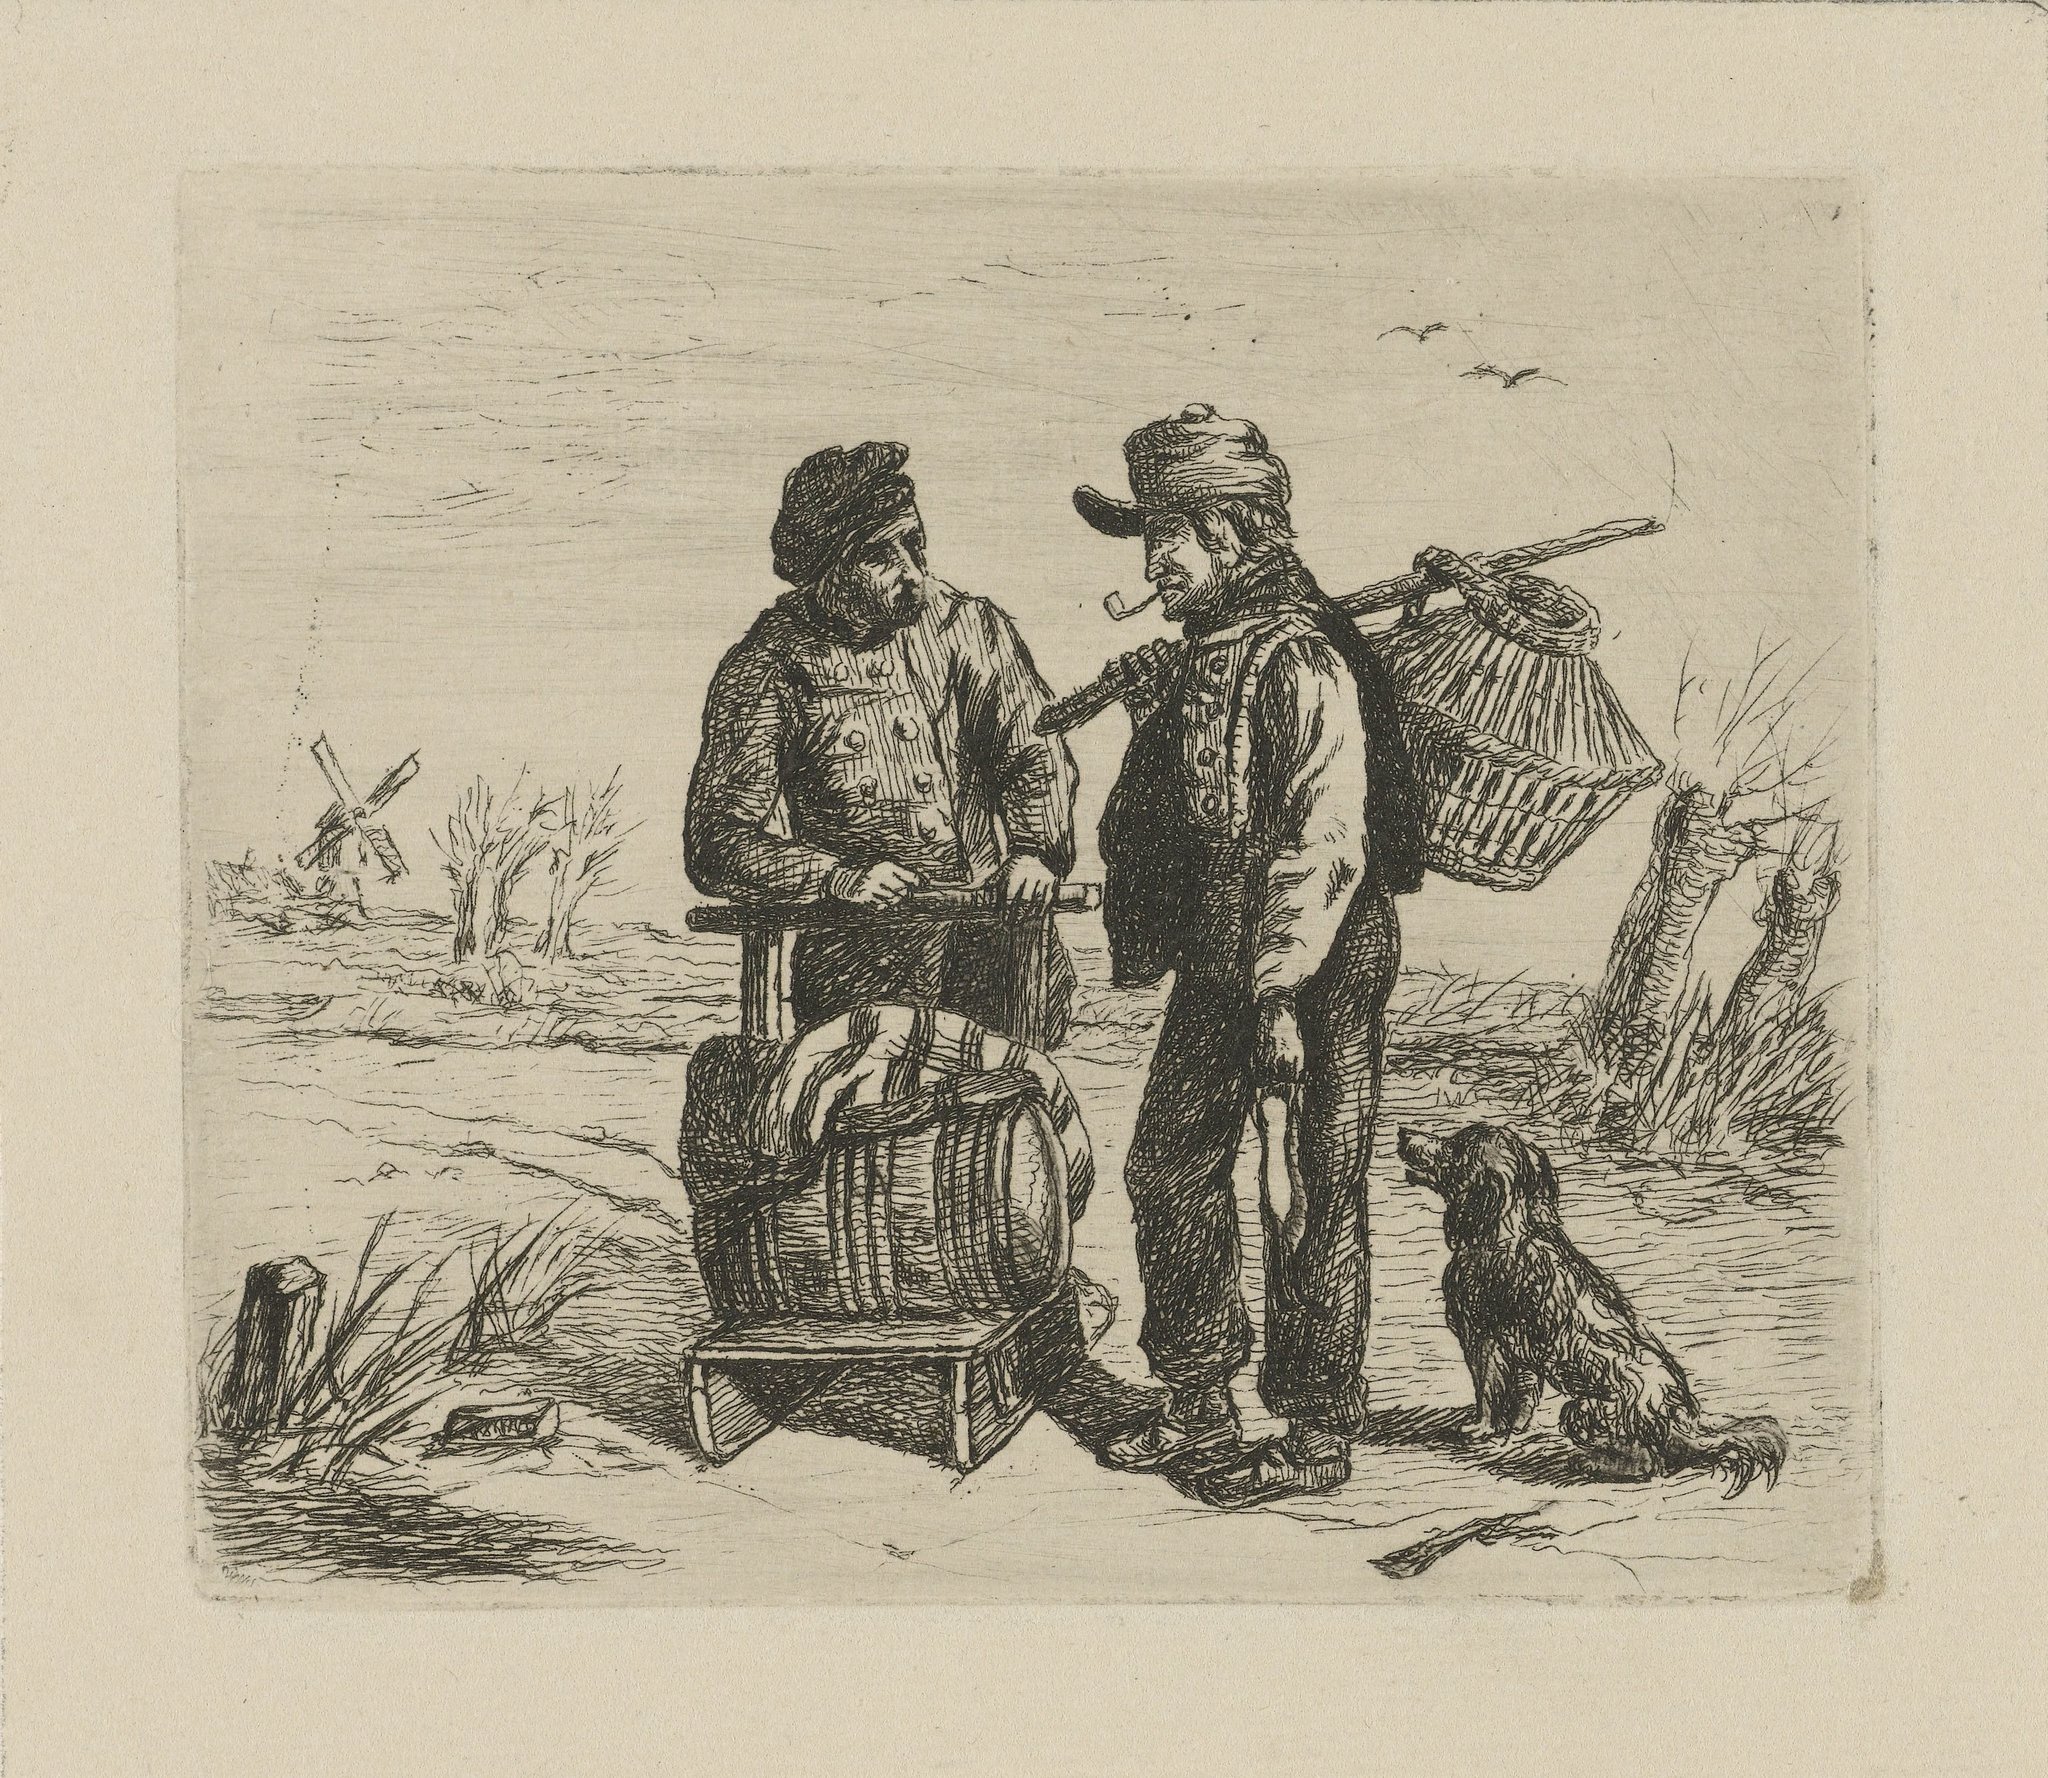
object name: print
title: Wintergezicht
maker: david van der kellen (1804-1879)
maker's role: die cutter, draughtsman, print maker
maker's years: 1804-1879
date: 1814-1878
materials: paper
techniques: etching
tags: trees, winter landscape; landscape symbolizing winter (the four seasons of the year), windmill in landscape, dog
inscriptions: collector's mark: Lugt 2228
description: Wintergezicht met twee mannen die met elkaar in gesprek zijn. Een van de mannen heeft een slede bij zich, waarop een ton ligt. De ander, mogelijk een kippenboer, rookt een pijp en heeft een hond bij zich. Op de achtergrond enkele knotwilgen en een windmolen.